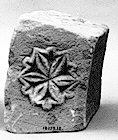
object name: voussoir fragment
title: Block from an Arch with a Rosette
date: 501-700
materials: stone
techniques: carving, relief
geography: egypt